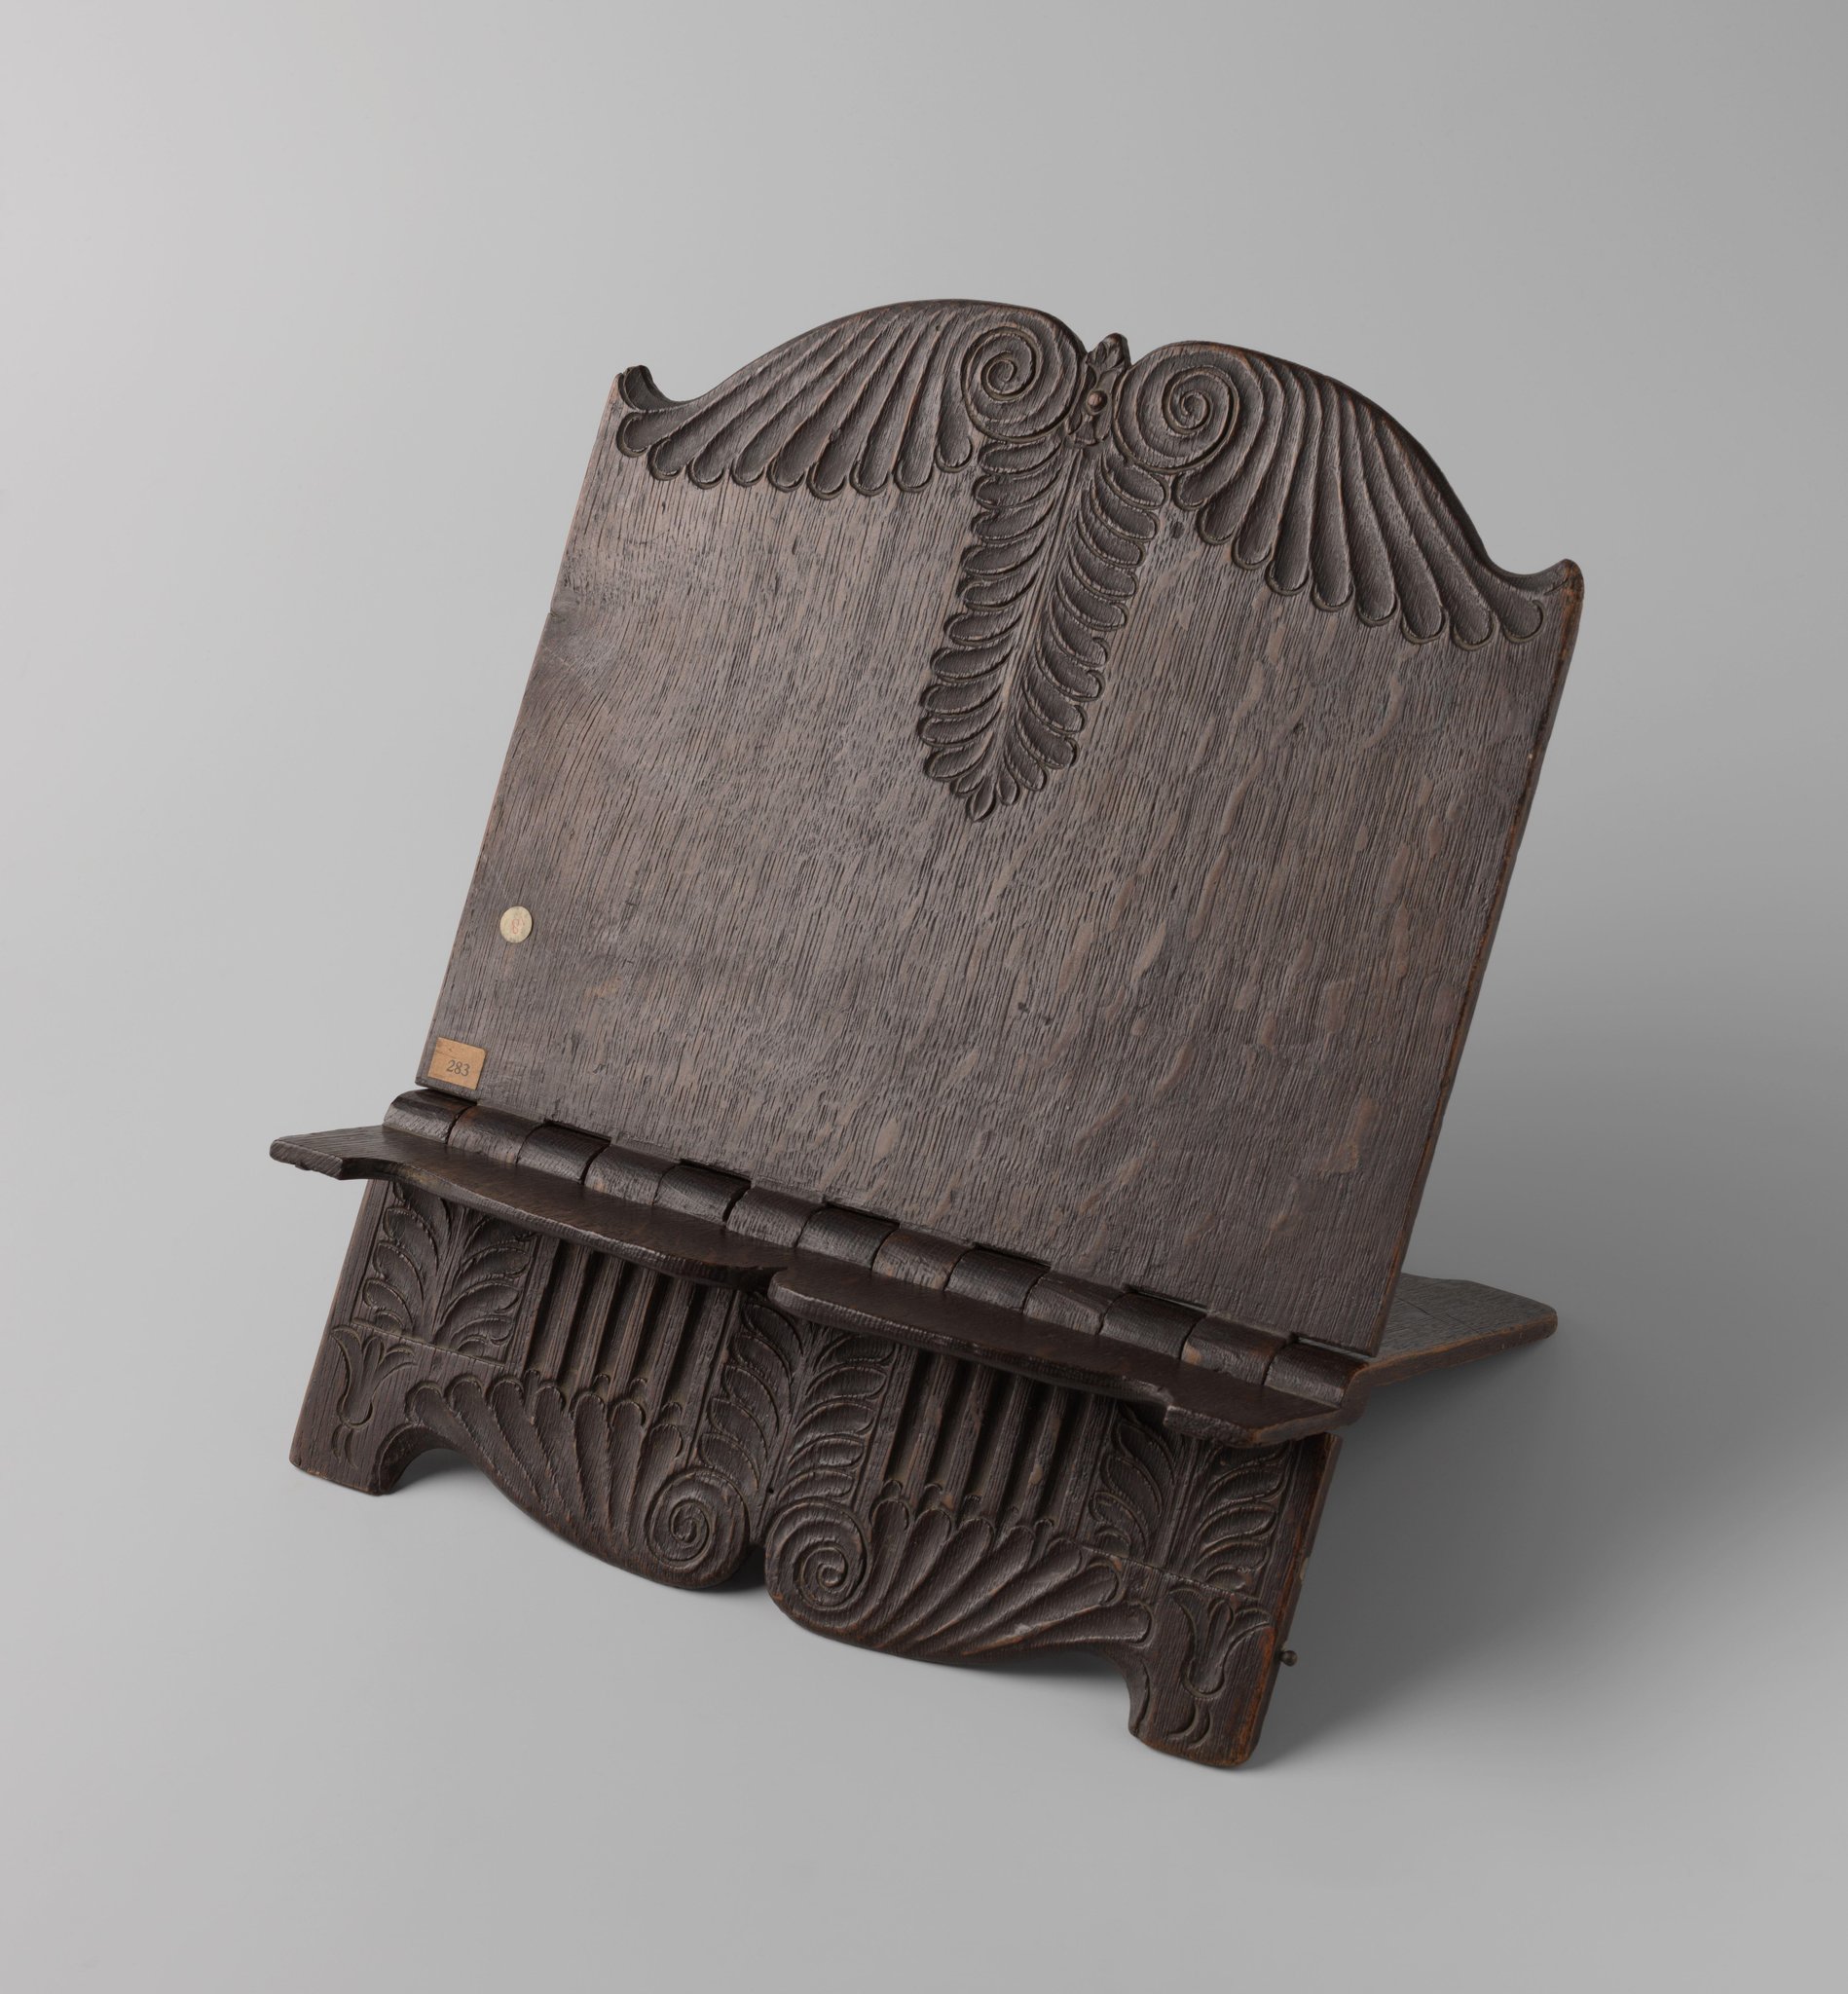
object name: lectern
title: Lessenaar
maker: Anonymous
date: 1600-1699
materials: wood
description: Lessenaar van eikenhout. Opmerking: identiek aan BK-KOG-672.